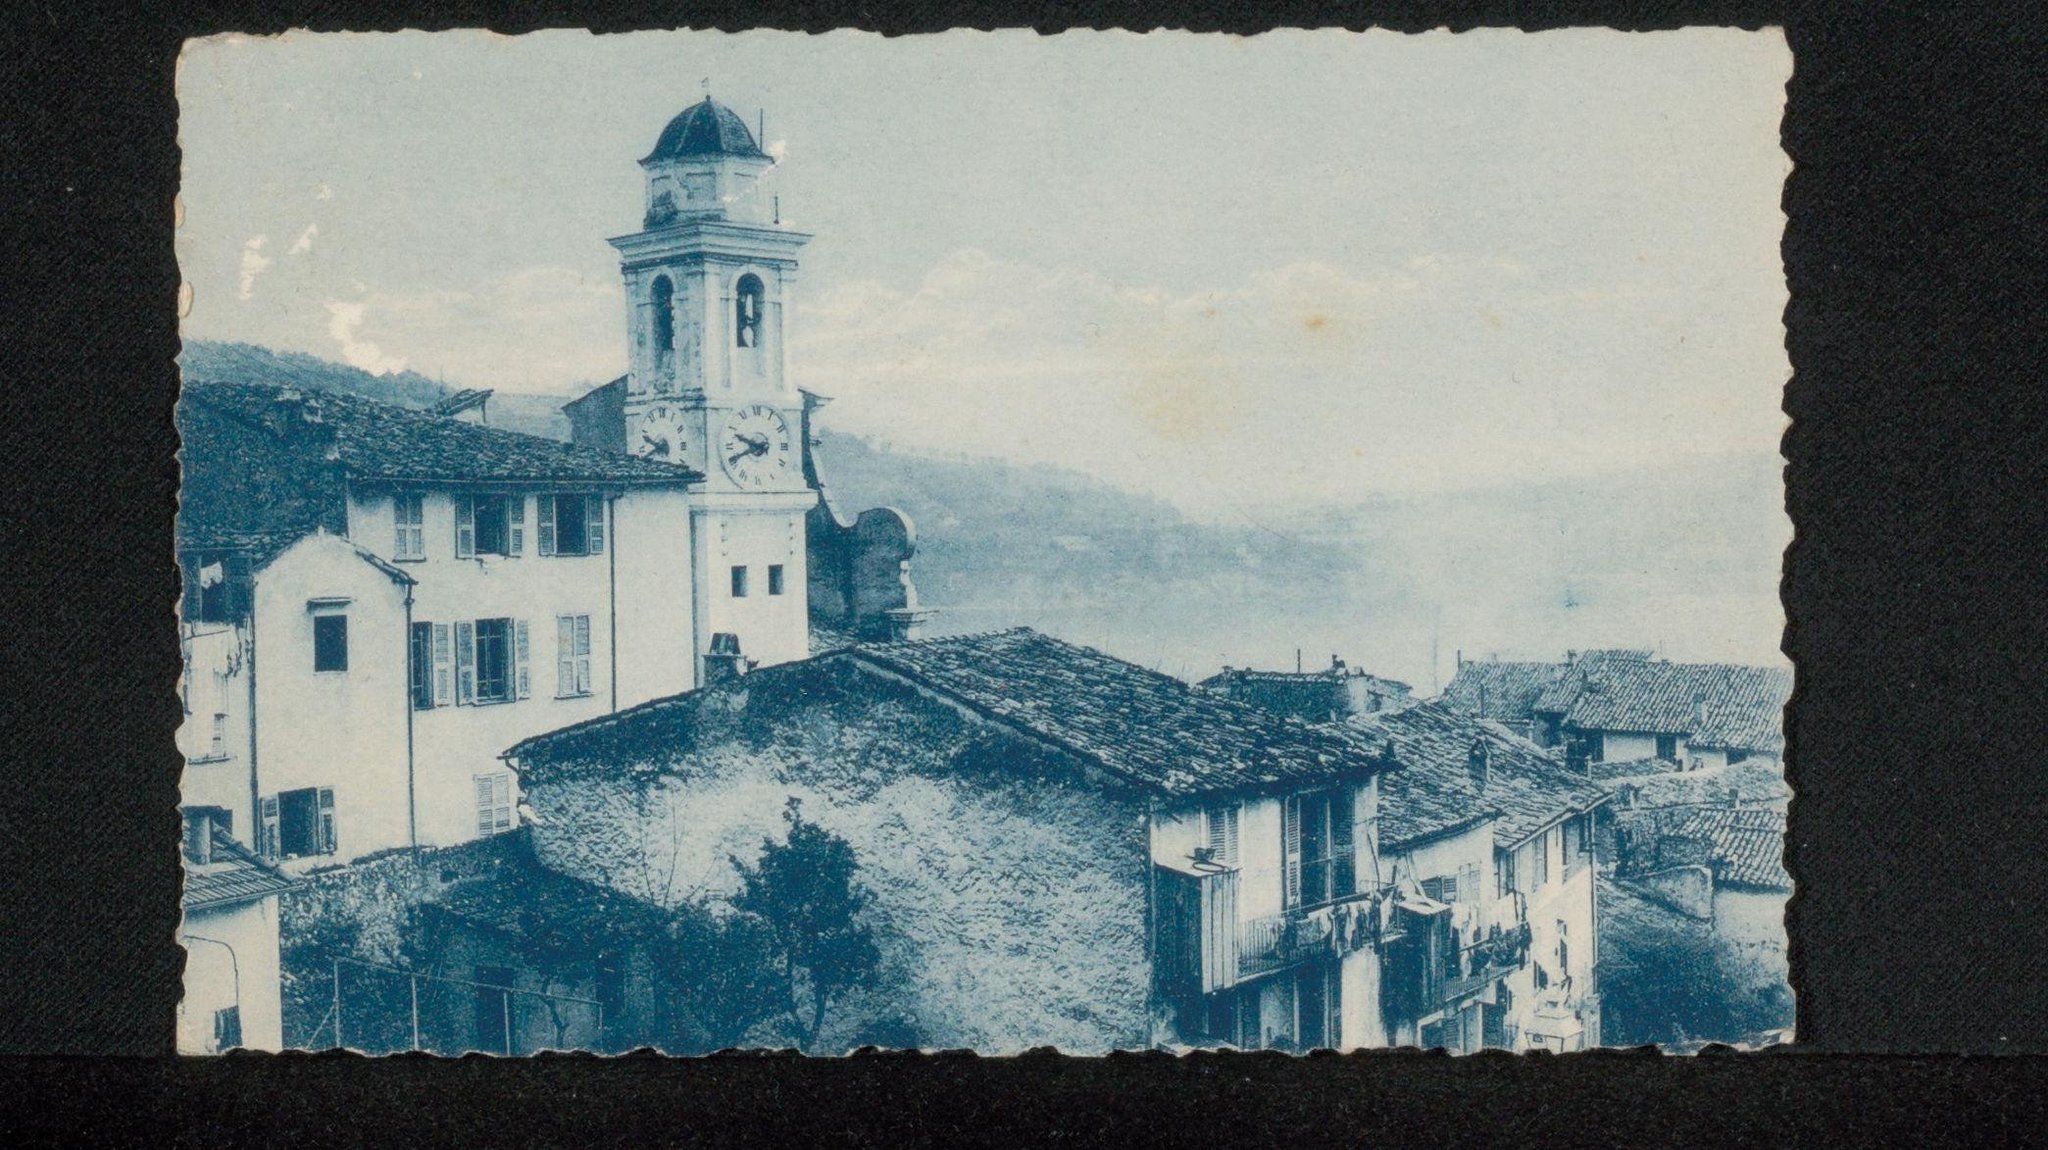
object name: ansichtkaart, prentbriefkaart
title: Prentbriefkaart aan Philip Zilcken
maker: rose imel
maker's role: draughtsman, painter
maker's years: 1901-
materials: cardboard, ink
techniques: photograph, pen, writing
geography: paris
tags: painter, draughtsman, philip zilcken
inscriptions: collector's mark: ‘RPK’